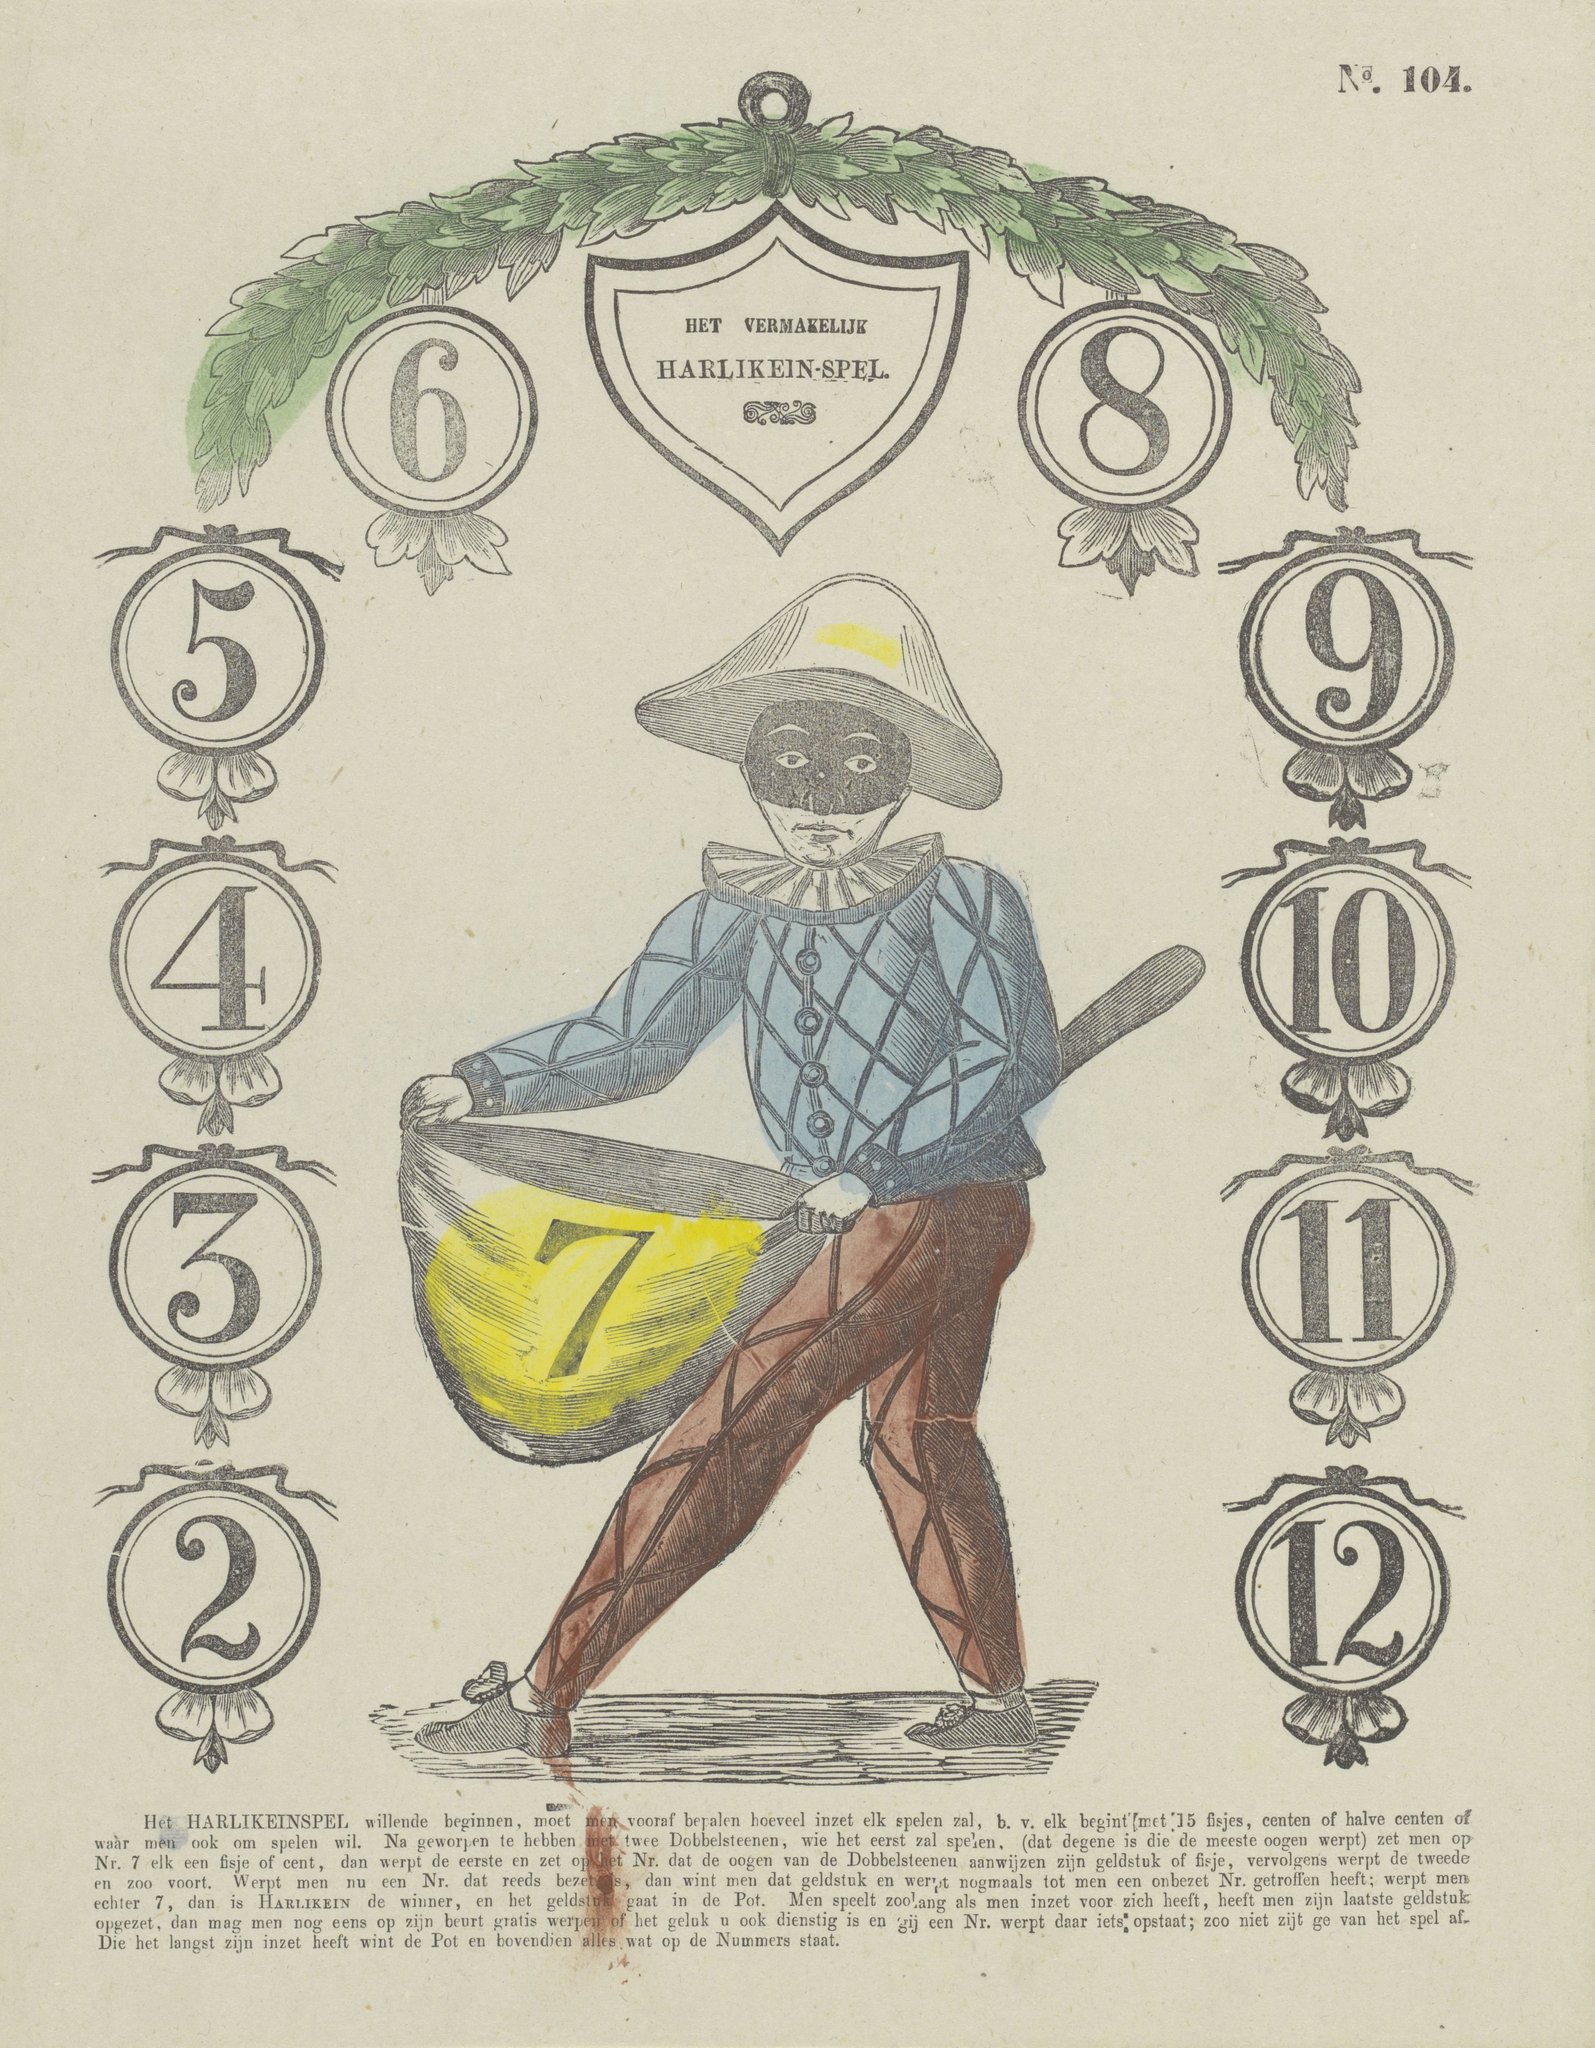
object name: print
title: Het vermakelijk harlekein-spel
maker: Anonymous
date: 1850-1870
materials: paper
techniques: colour, letterpress printing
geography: netherlands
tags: board-games of chance, types in 'commedia dell'arte': harlequin, board-games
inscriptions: collector's mark: Lugt 2760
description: Bordspel met in het midden van het speelveld een harlekijn die in zijn geopende handen een zak houdt met daarop het cijfer 7. Rondom hem een guirlande waaraan medaillons hangen met de cijfers 2 tot en met 12. Bovenaan in het midden een schild. Onder de voorstelling de spelregels in boekdruk. Genummerd rechtsboven: No. 104.